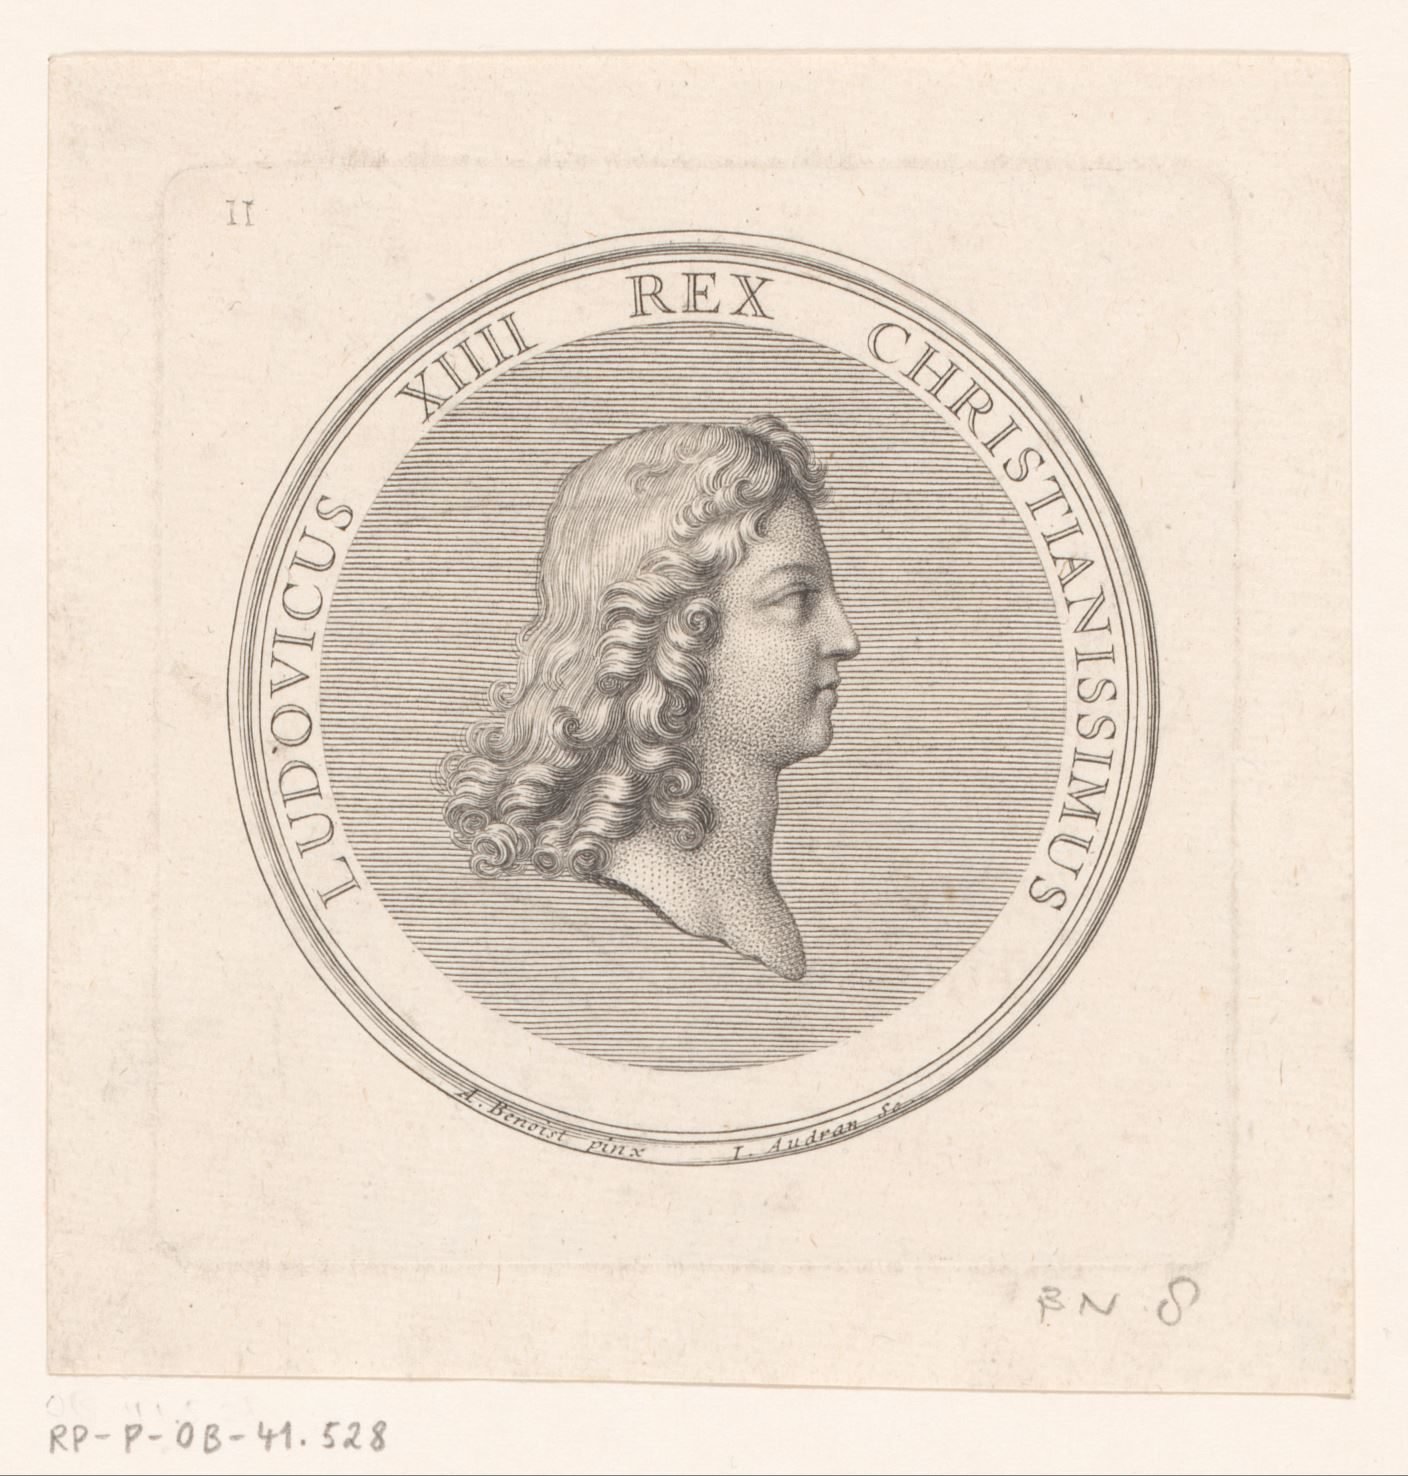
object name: print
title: Medaillon met portret van Lodewijk XIV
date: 1731-1756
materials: paper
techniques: etching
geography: france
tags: lodewijk xiv (koning van frankrijk), ornament ~ medallion, historical persons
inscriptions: collector's mark: Lugt 240